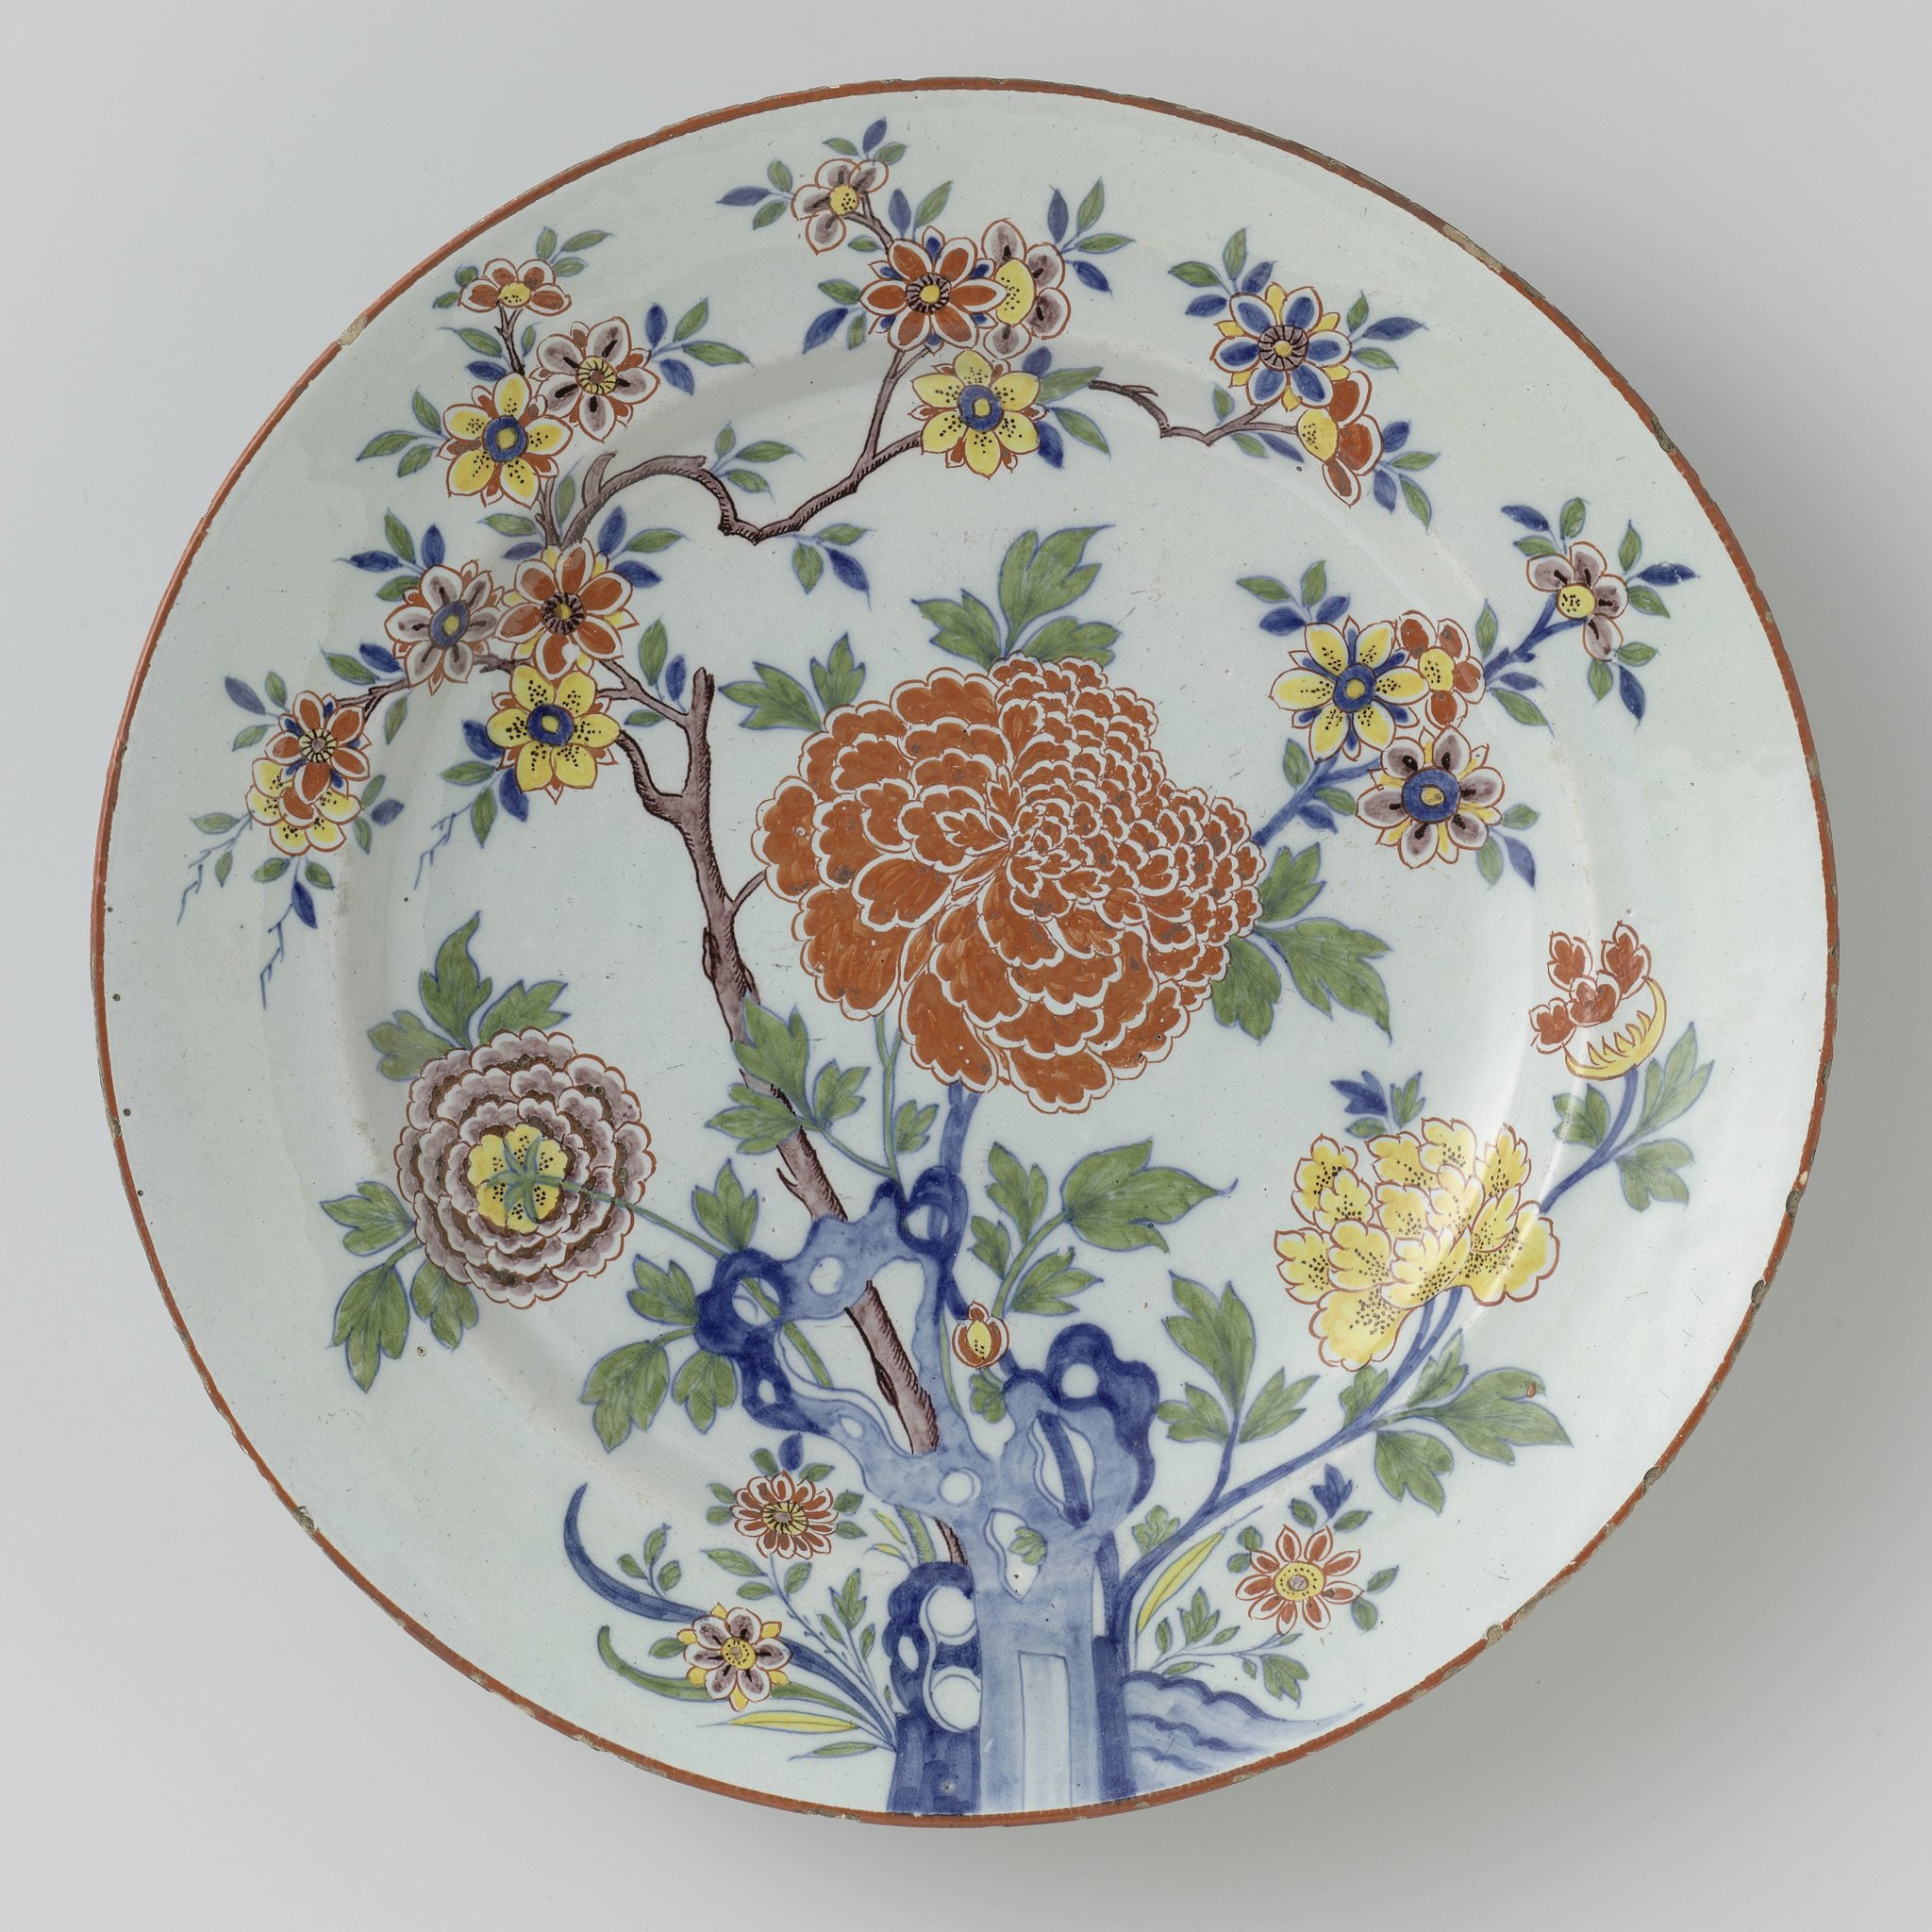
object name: platter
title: Schotel, veelkleurig beschilderd met Chinees bloemornament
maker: Anonymous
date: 1750-1775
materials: faience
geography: delft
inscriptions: collector's mark: ‘collection J.F. Loudon’, seal, on: ‘495’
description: Schotel van faïence. Veelkleurig beschilderd met Chinees bloemornament.